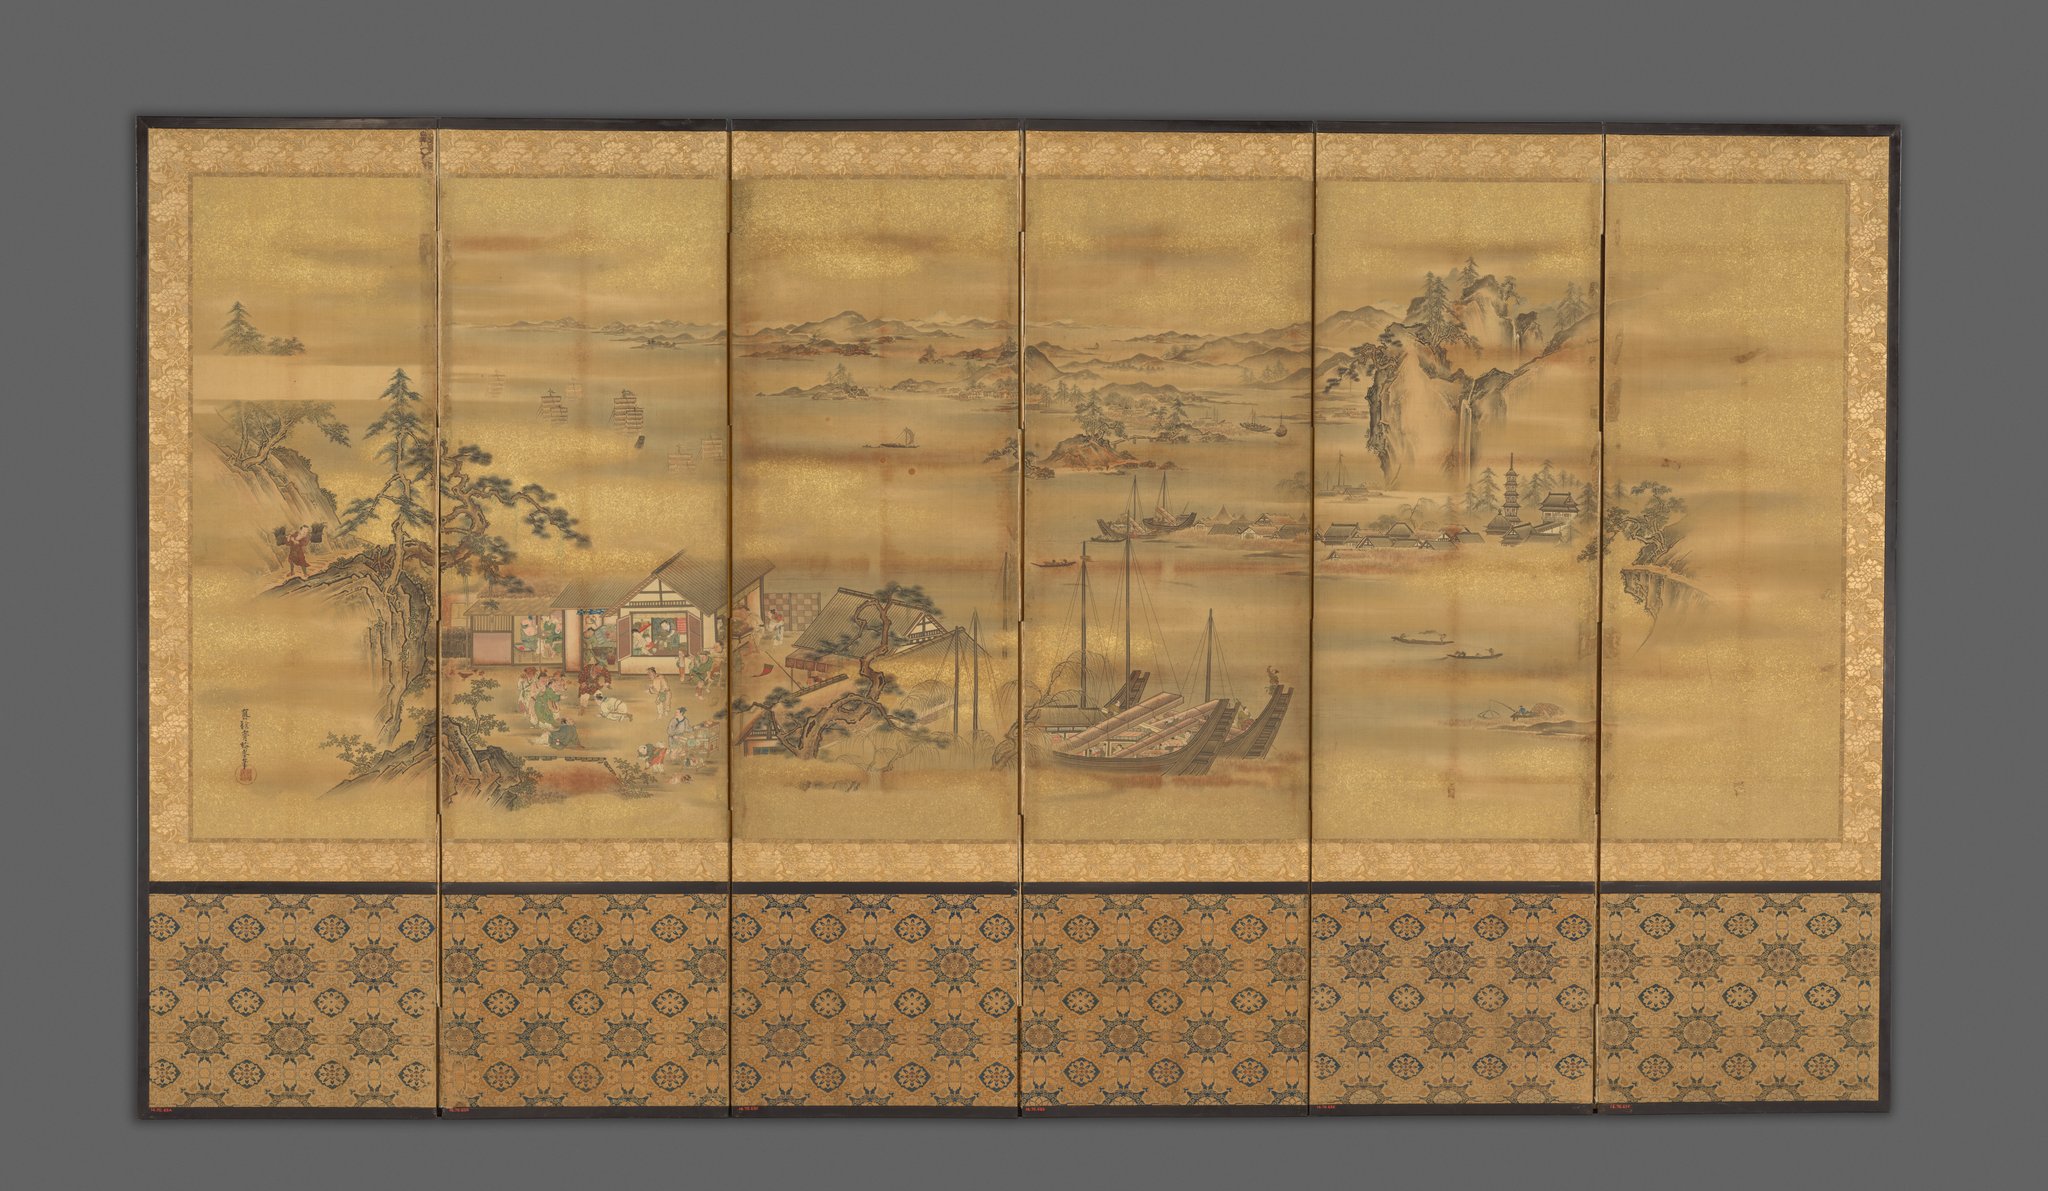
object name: screen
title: Fishing Village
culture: japanese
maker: andō baiho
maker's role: artist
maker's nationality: japanese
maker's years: 1777-1825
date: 1801-1900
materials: panel, silk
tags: villages,landscapes,boats